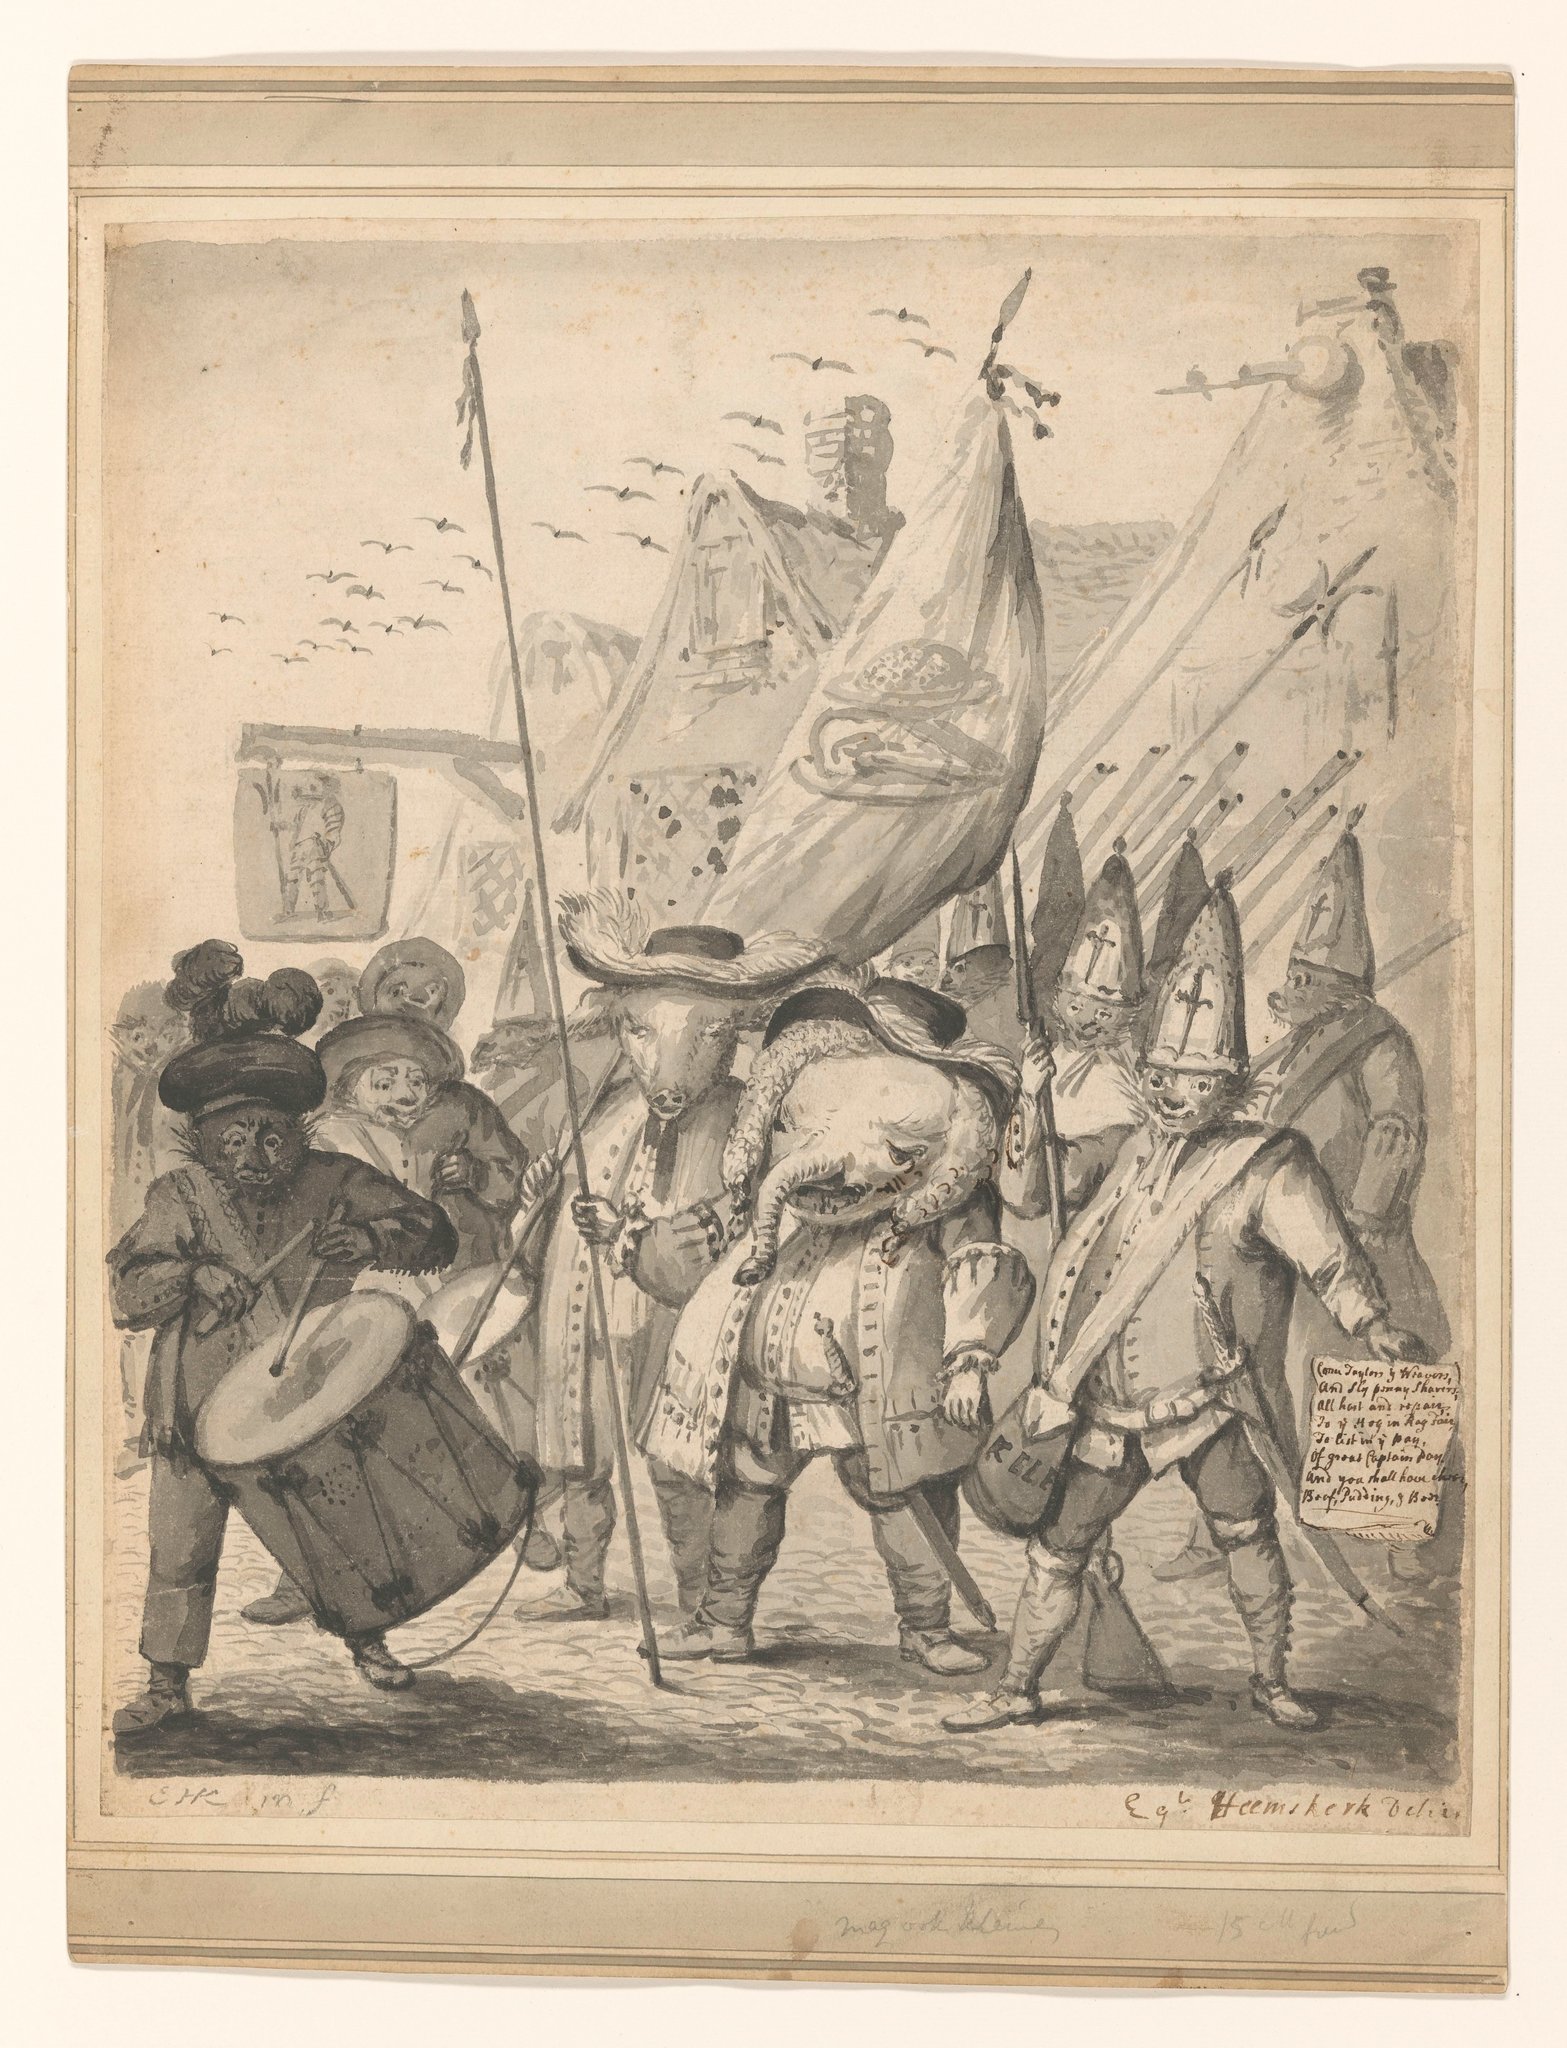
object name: drawing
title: Dierensatire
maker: egbert van heemskerck (ii)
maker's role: draughtsman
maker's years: 1666-1744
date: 1674-1744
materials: paper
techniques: brush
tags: cat, caricatures (human types), animals acting as human beings, inn, coffee-house, public house, etc., hoofed animals: pig, trunked animals: elephant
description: Een groep dieren, waaronder een olifant, een varken en katten, verkleed als soldaten, tamboer en officier staande voor enkele huizen.